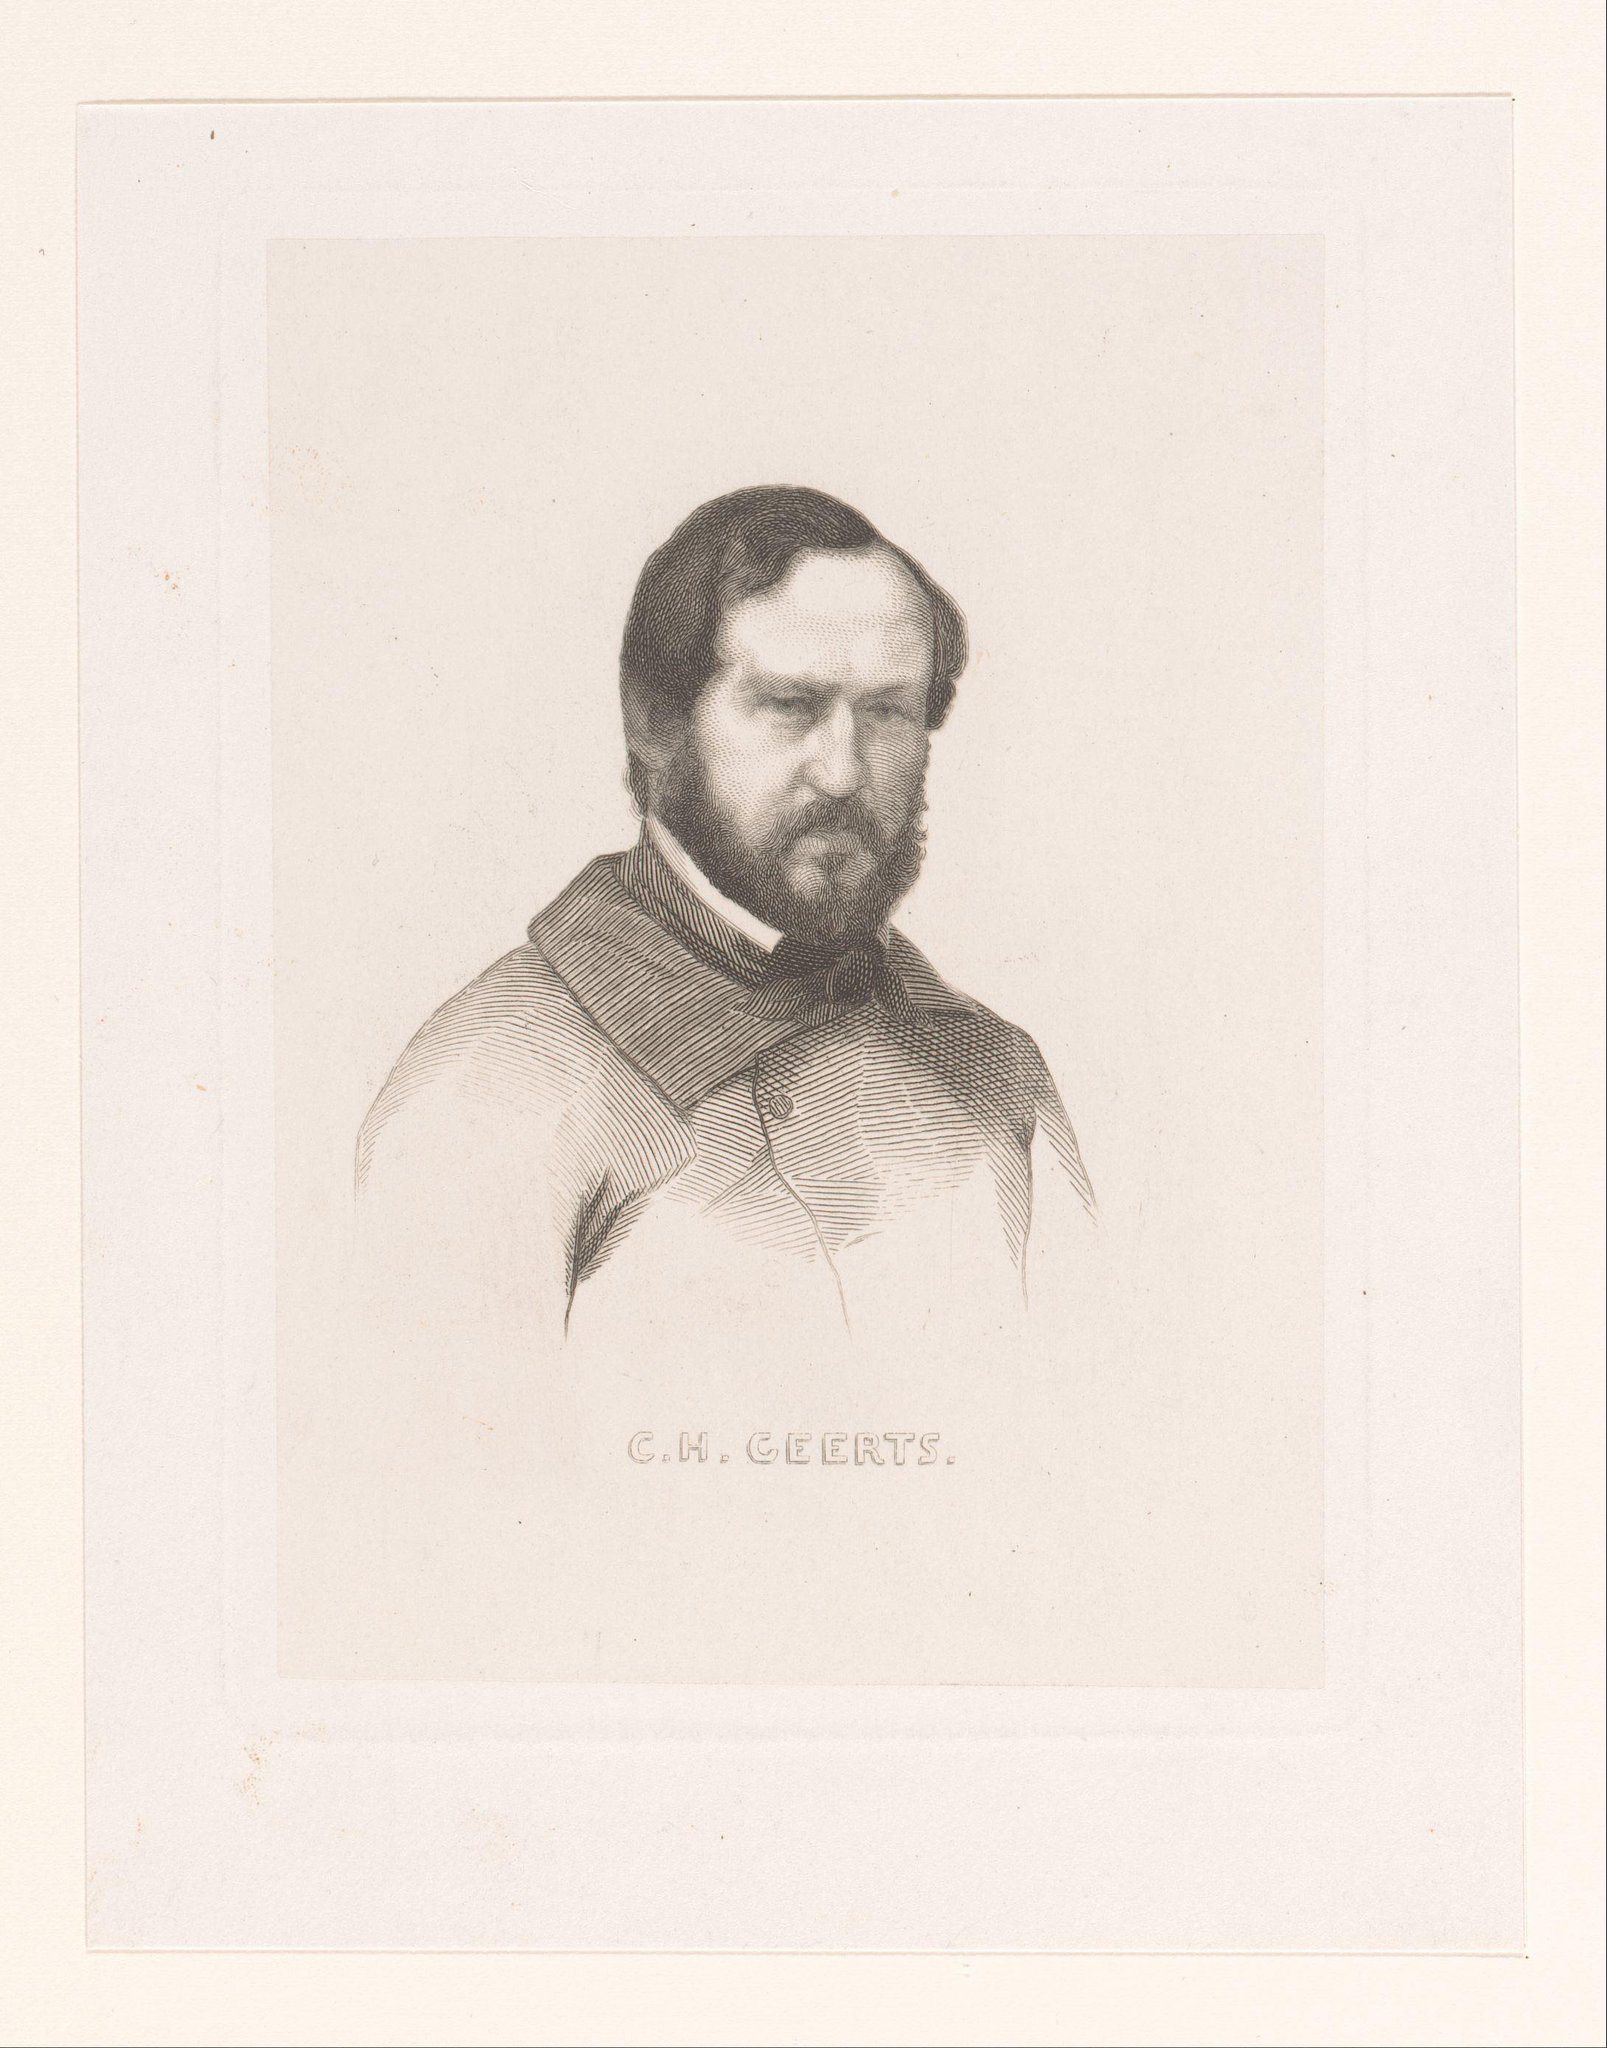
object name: print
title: C.H. Geerts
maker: joseph arnold demannez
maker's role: print maker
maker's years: 1826-1902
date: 1836-1902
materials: paper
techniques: engraving, etching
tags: adult man, historical persons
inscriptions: collector's mark: Lugt 2166, collector's mark: Lugt 2760